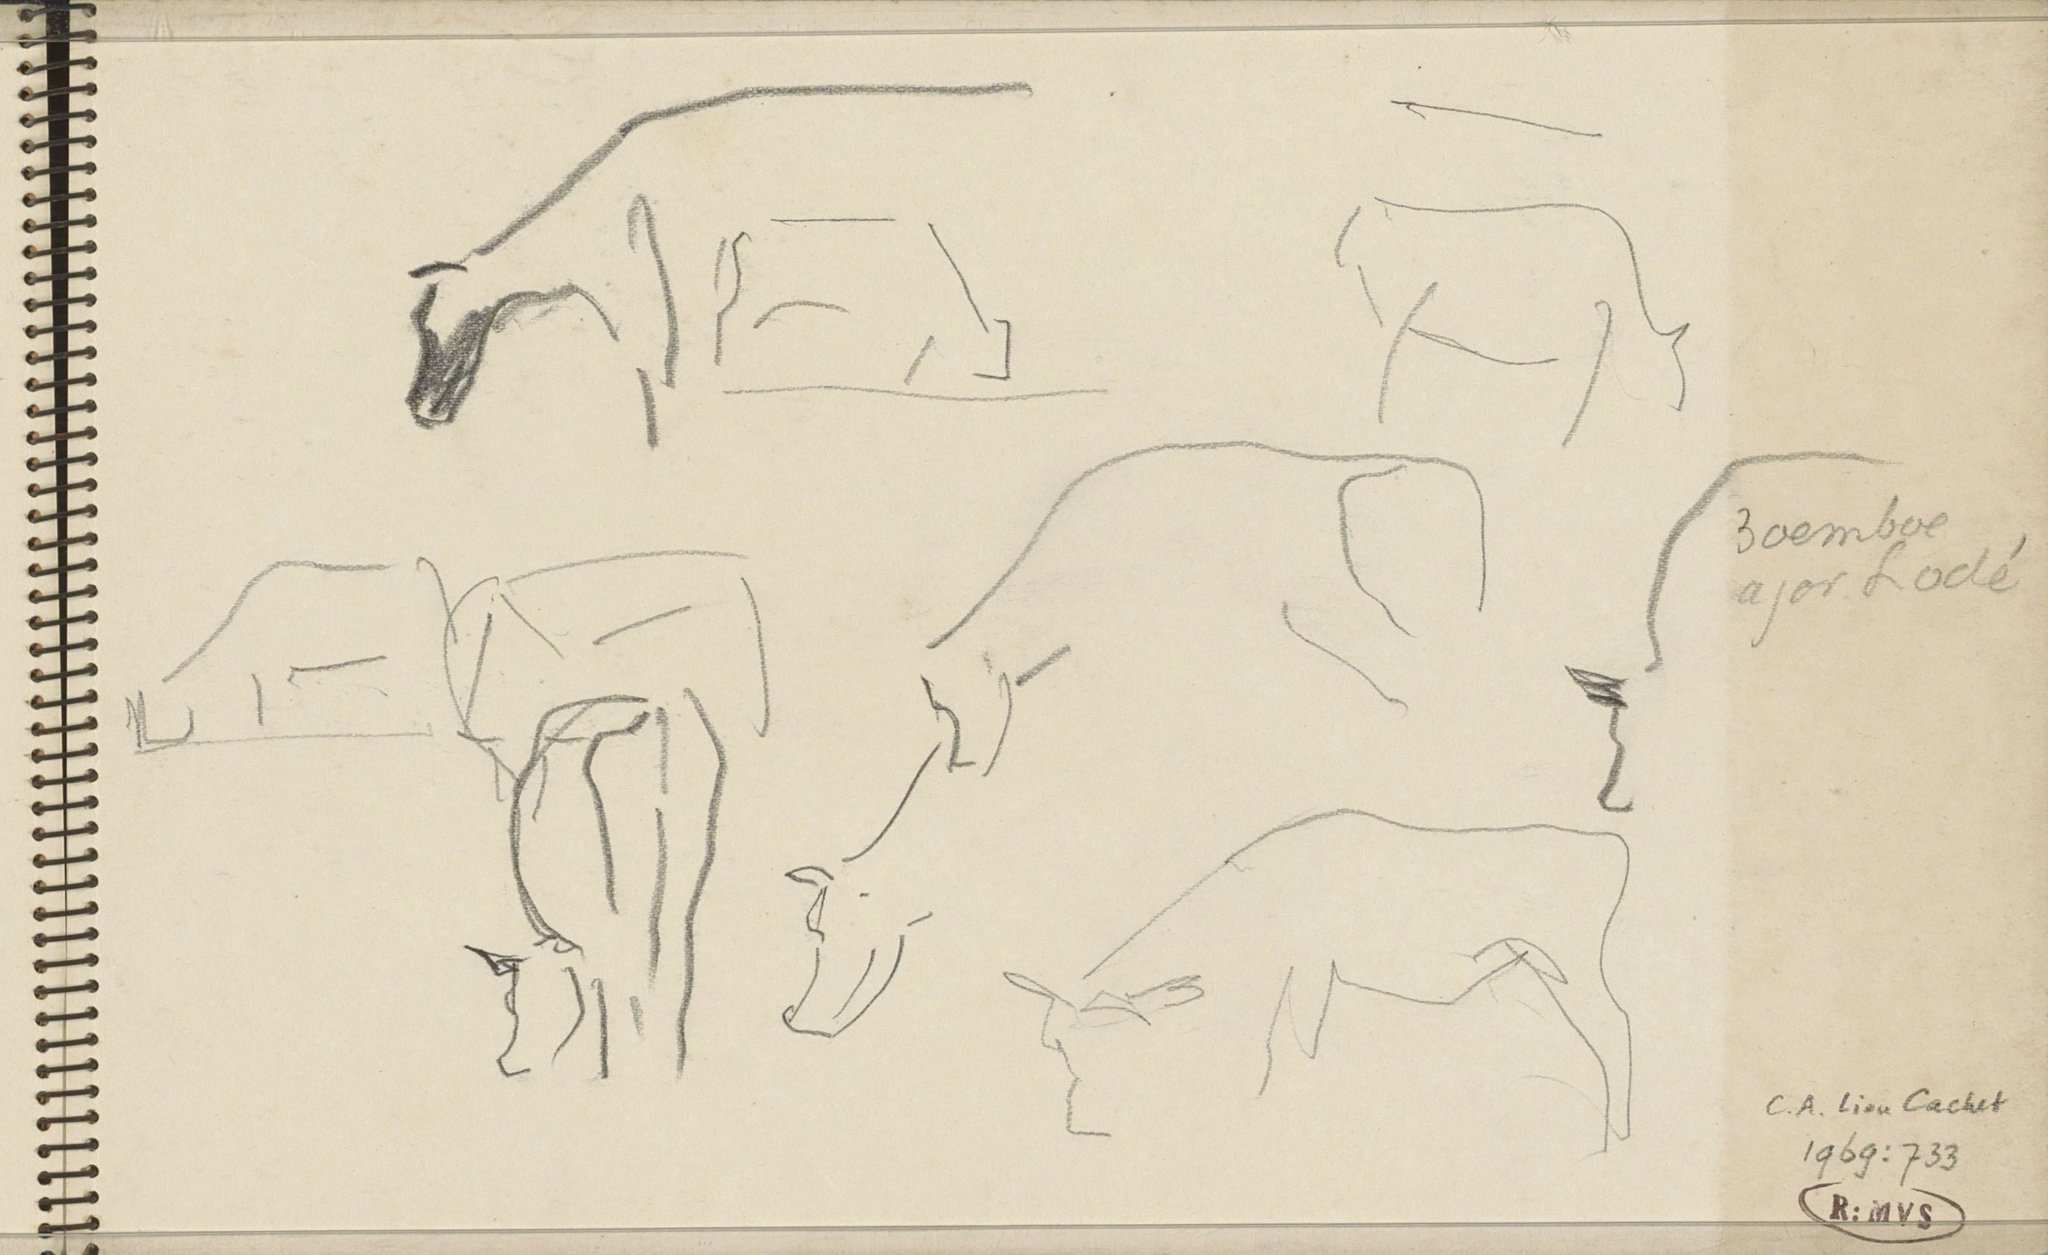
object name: sketchbook leaf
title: Koeien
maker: carel adolph lion cachet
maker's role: draughtsman, print maker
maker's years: 1864-1945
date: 1928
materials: paper, pencil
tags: cow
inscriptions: annotation: ‘Boemboe/ Sajor Lodé’, collector's mark: Lugt 2228a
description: Blad 2 recto uit een schetsboek met 12 bladen.